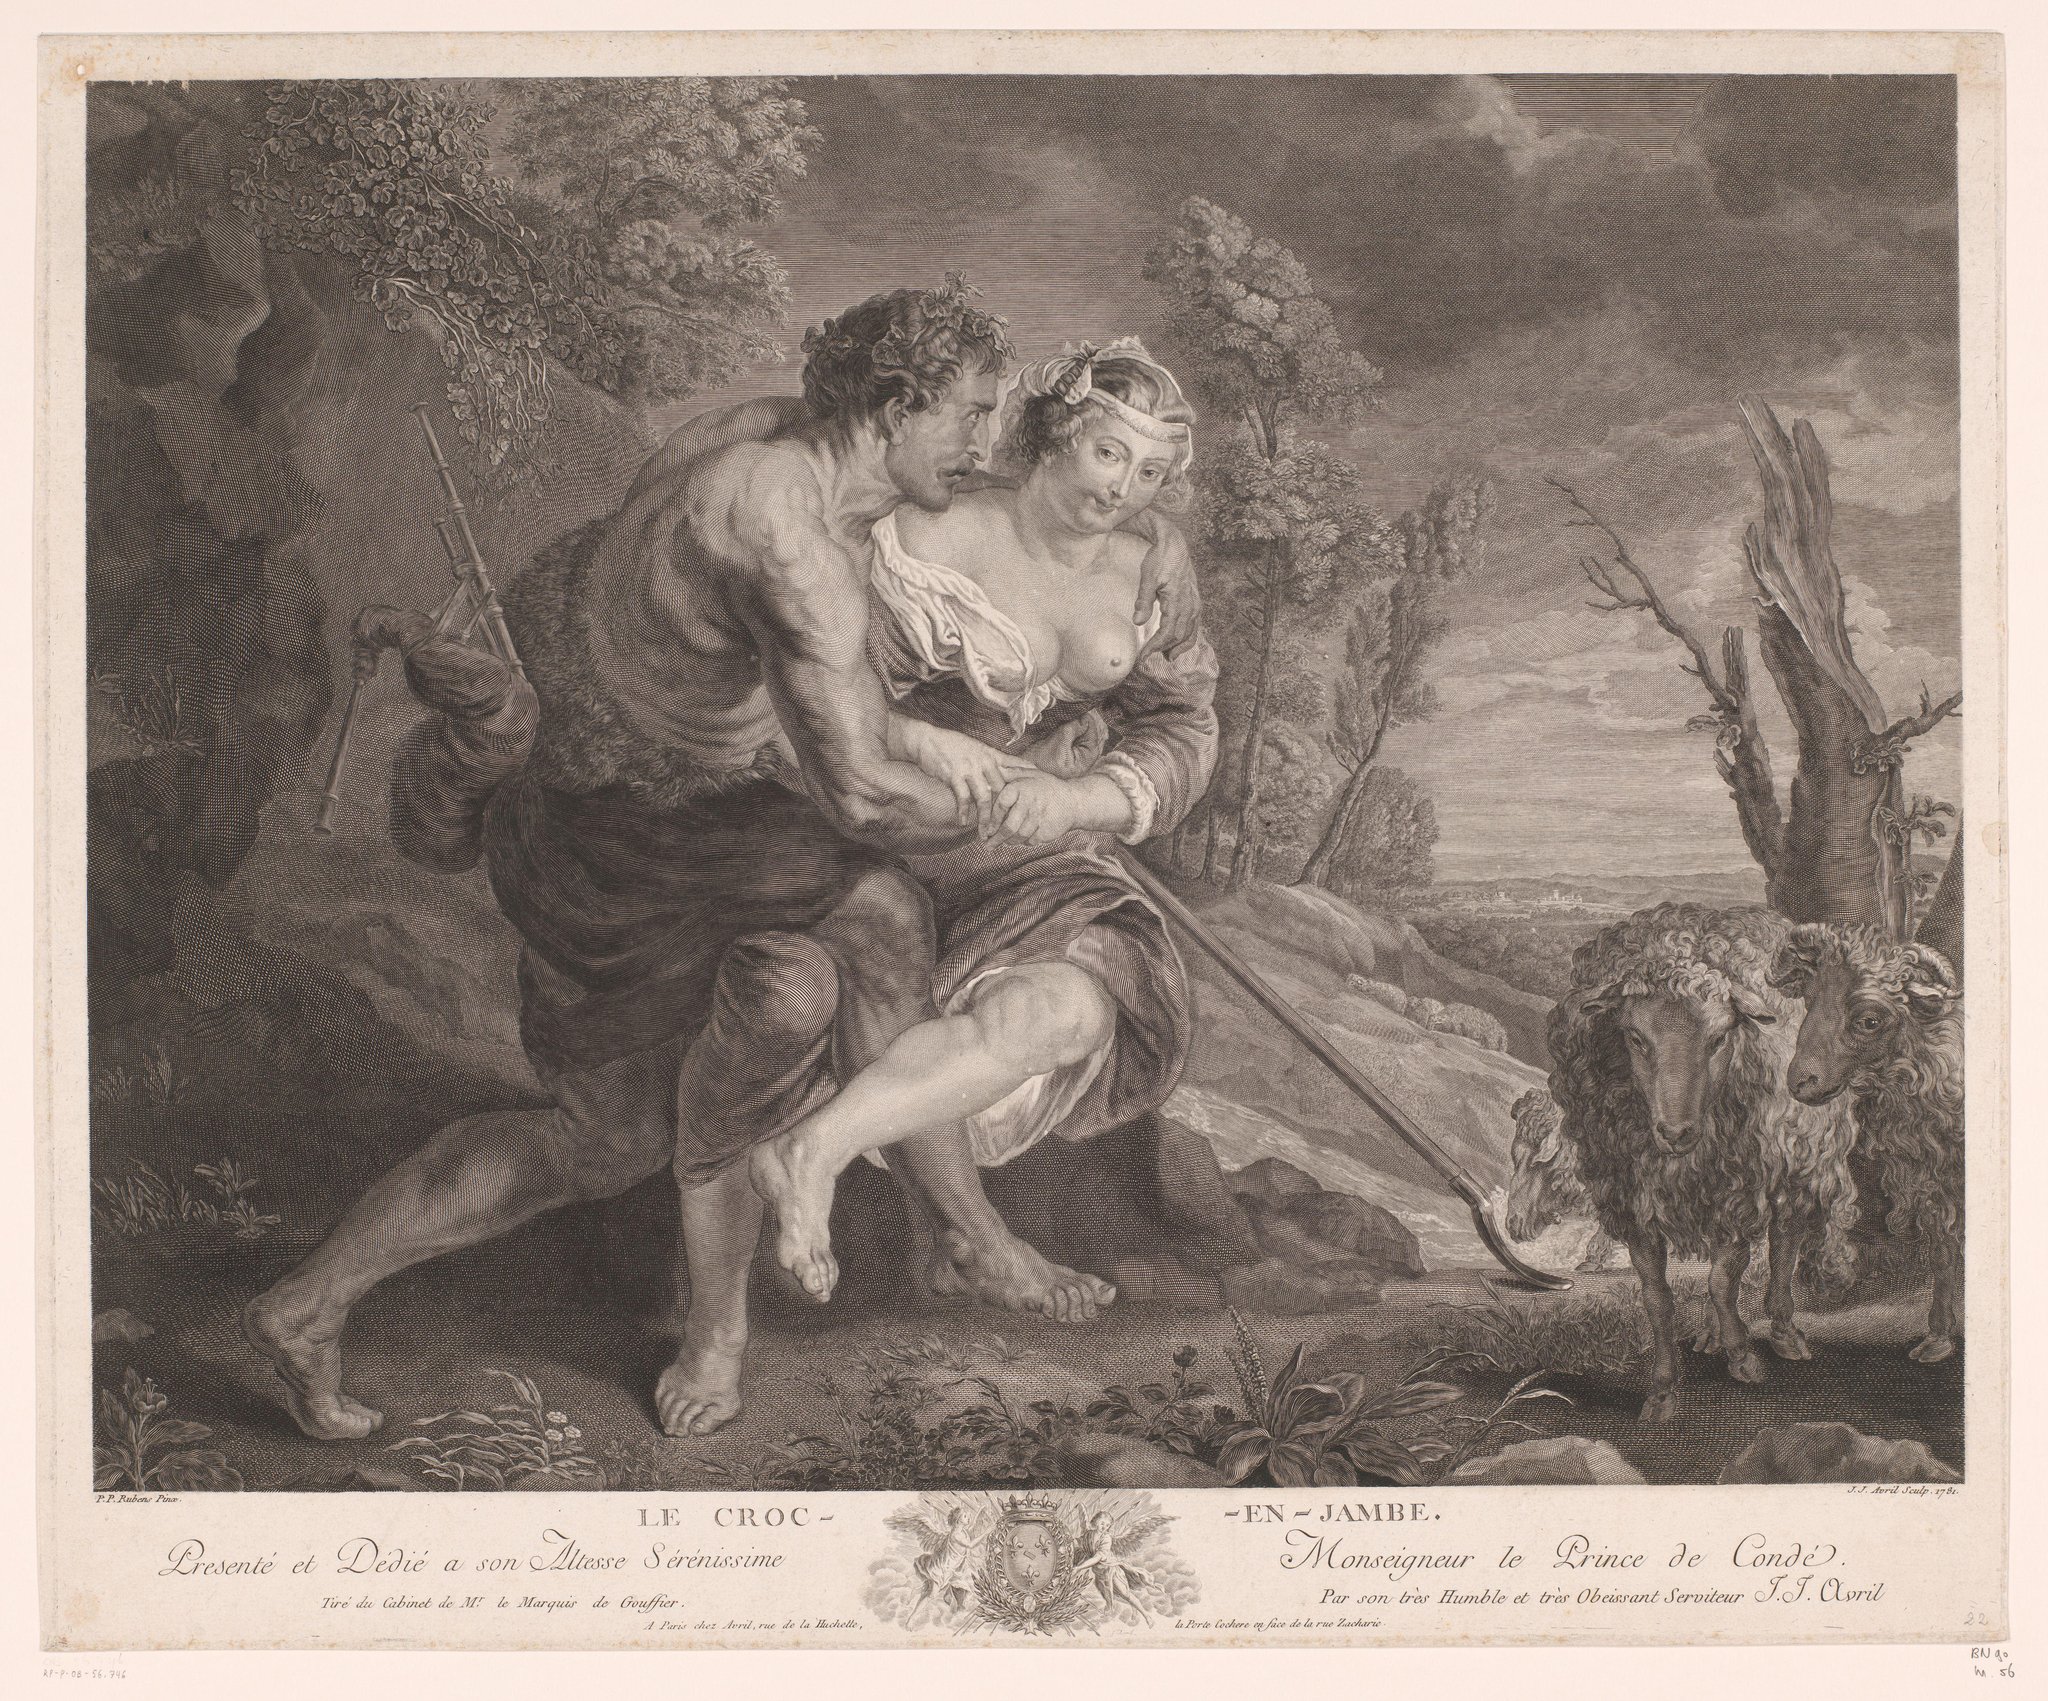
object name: print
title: Le croc-en-jambe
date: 1781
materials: paper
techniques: engraving, etching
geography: paris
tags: stumbling - aa - female human figure, sheep, armorial bearing, heraldry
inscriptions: collector's mark: Lugt 240